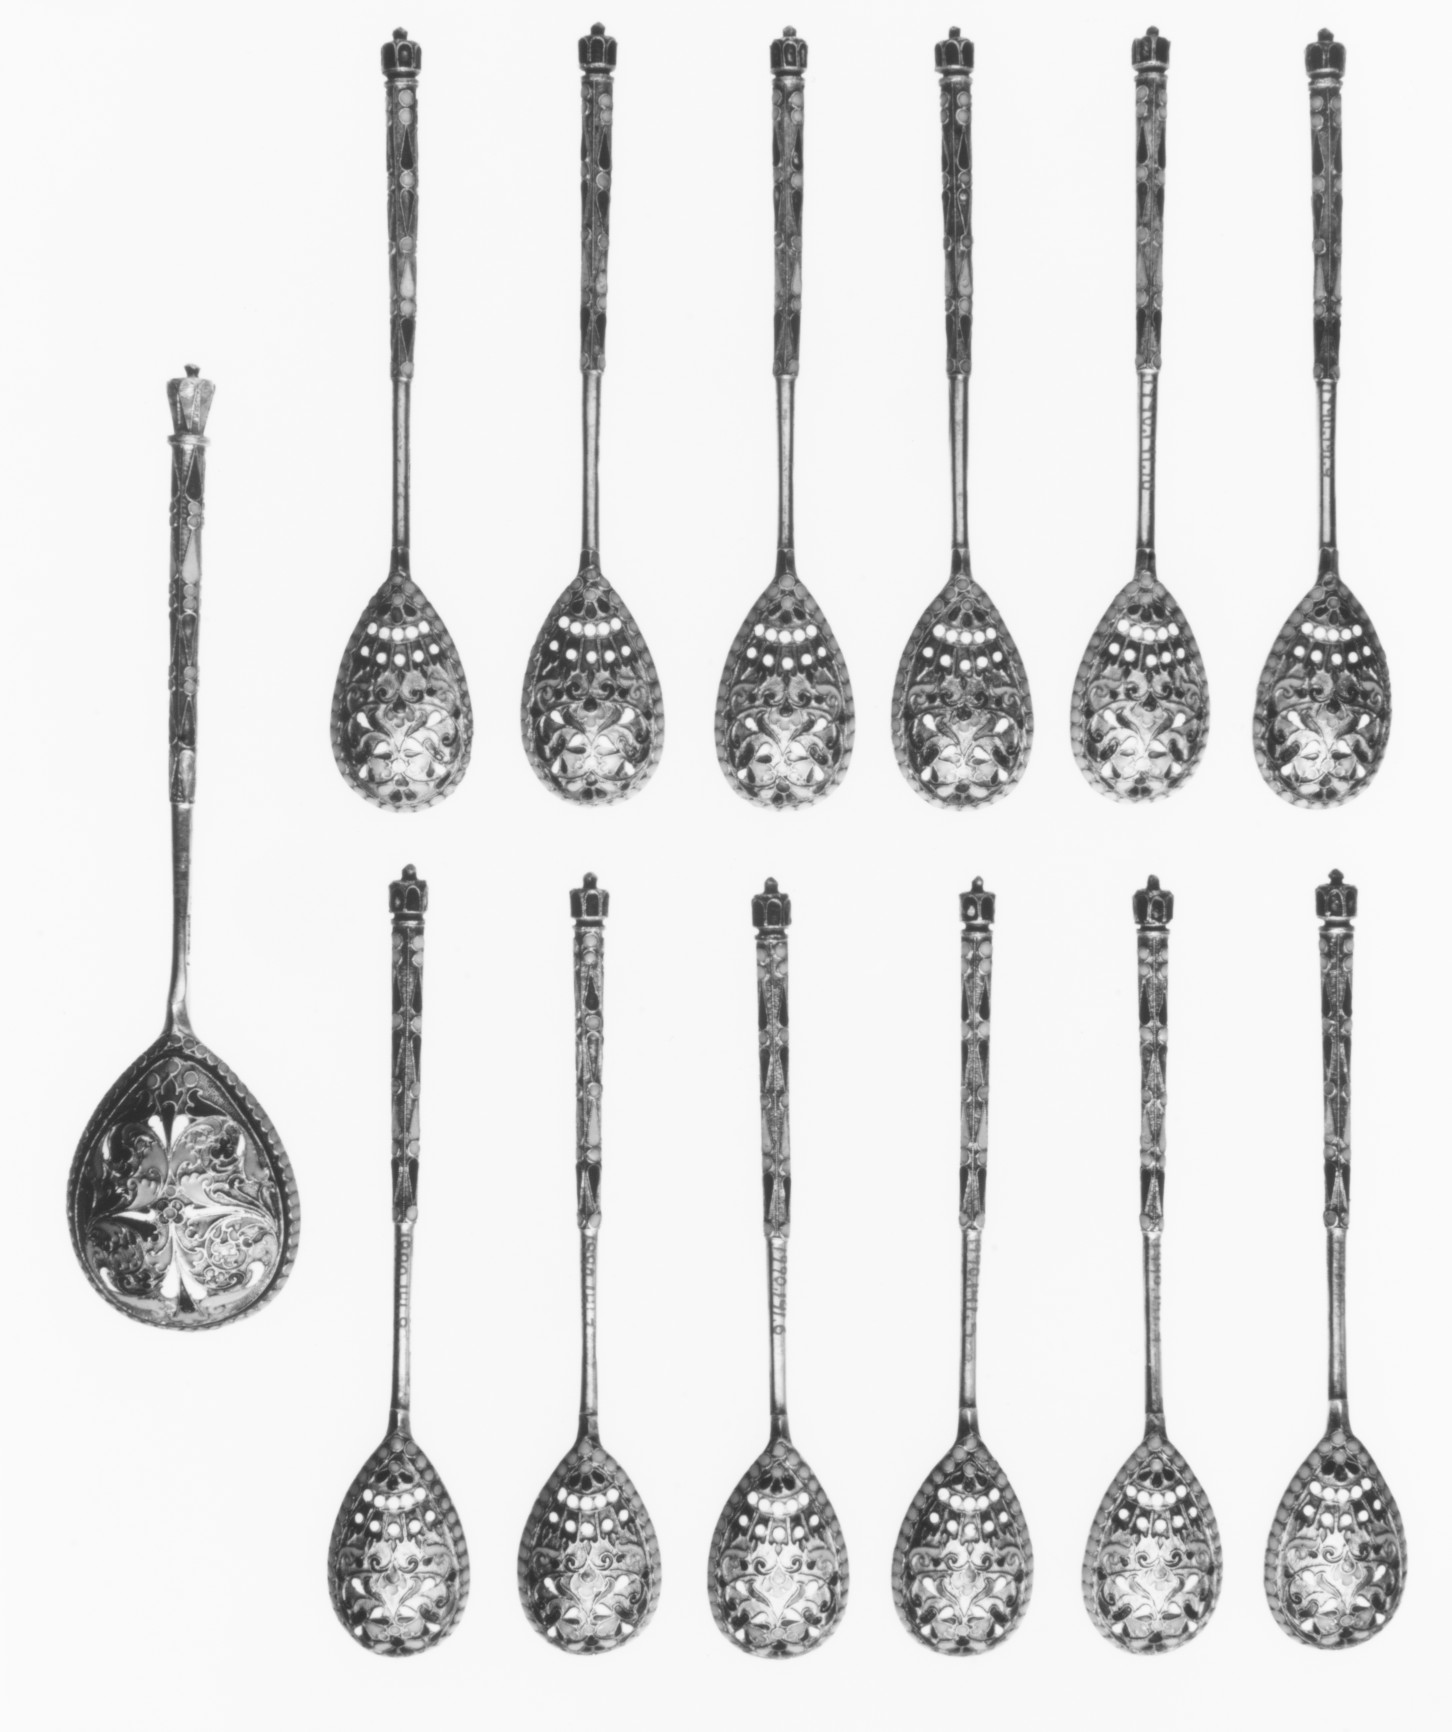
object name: teaspoon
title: Twelve long-handled teaspoons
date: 1895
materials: enamel, silver